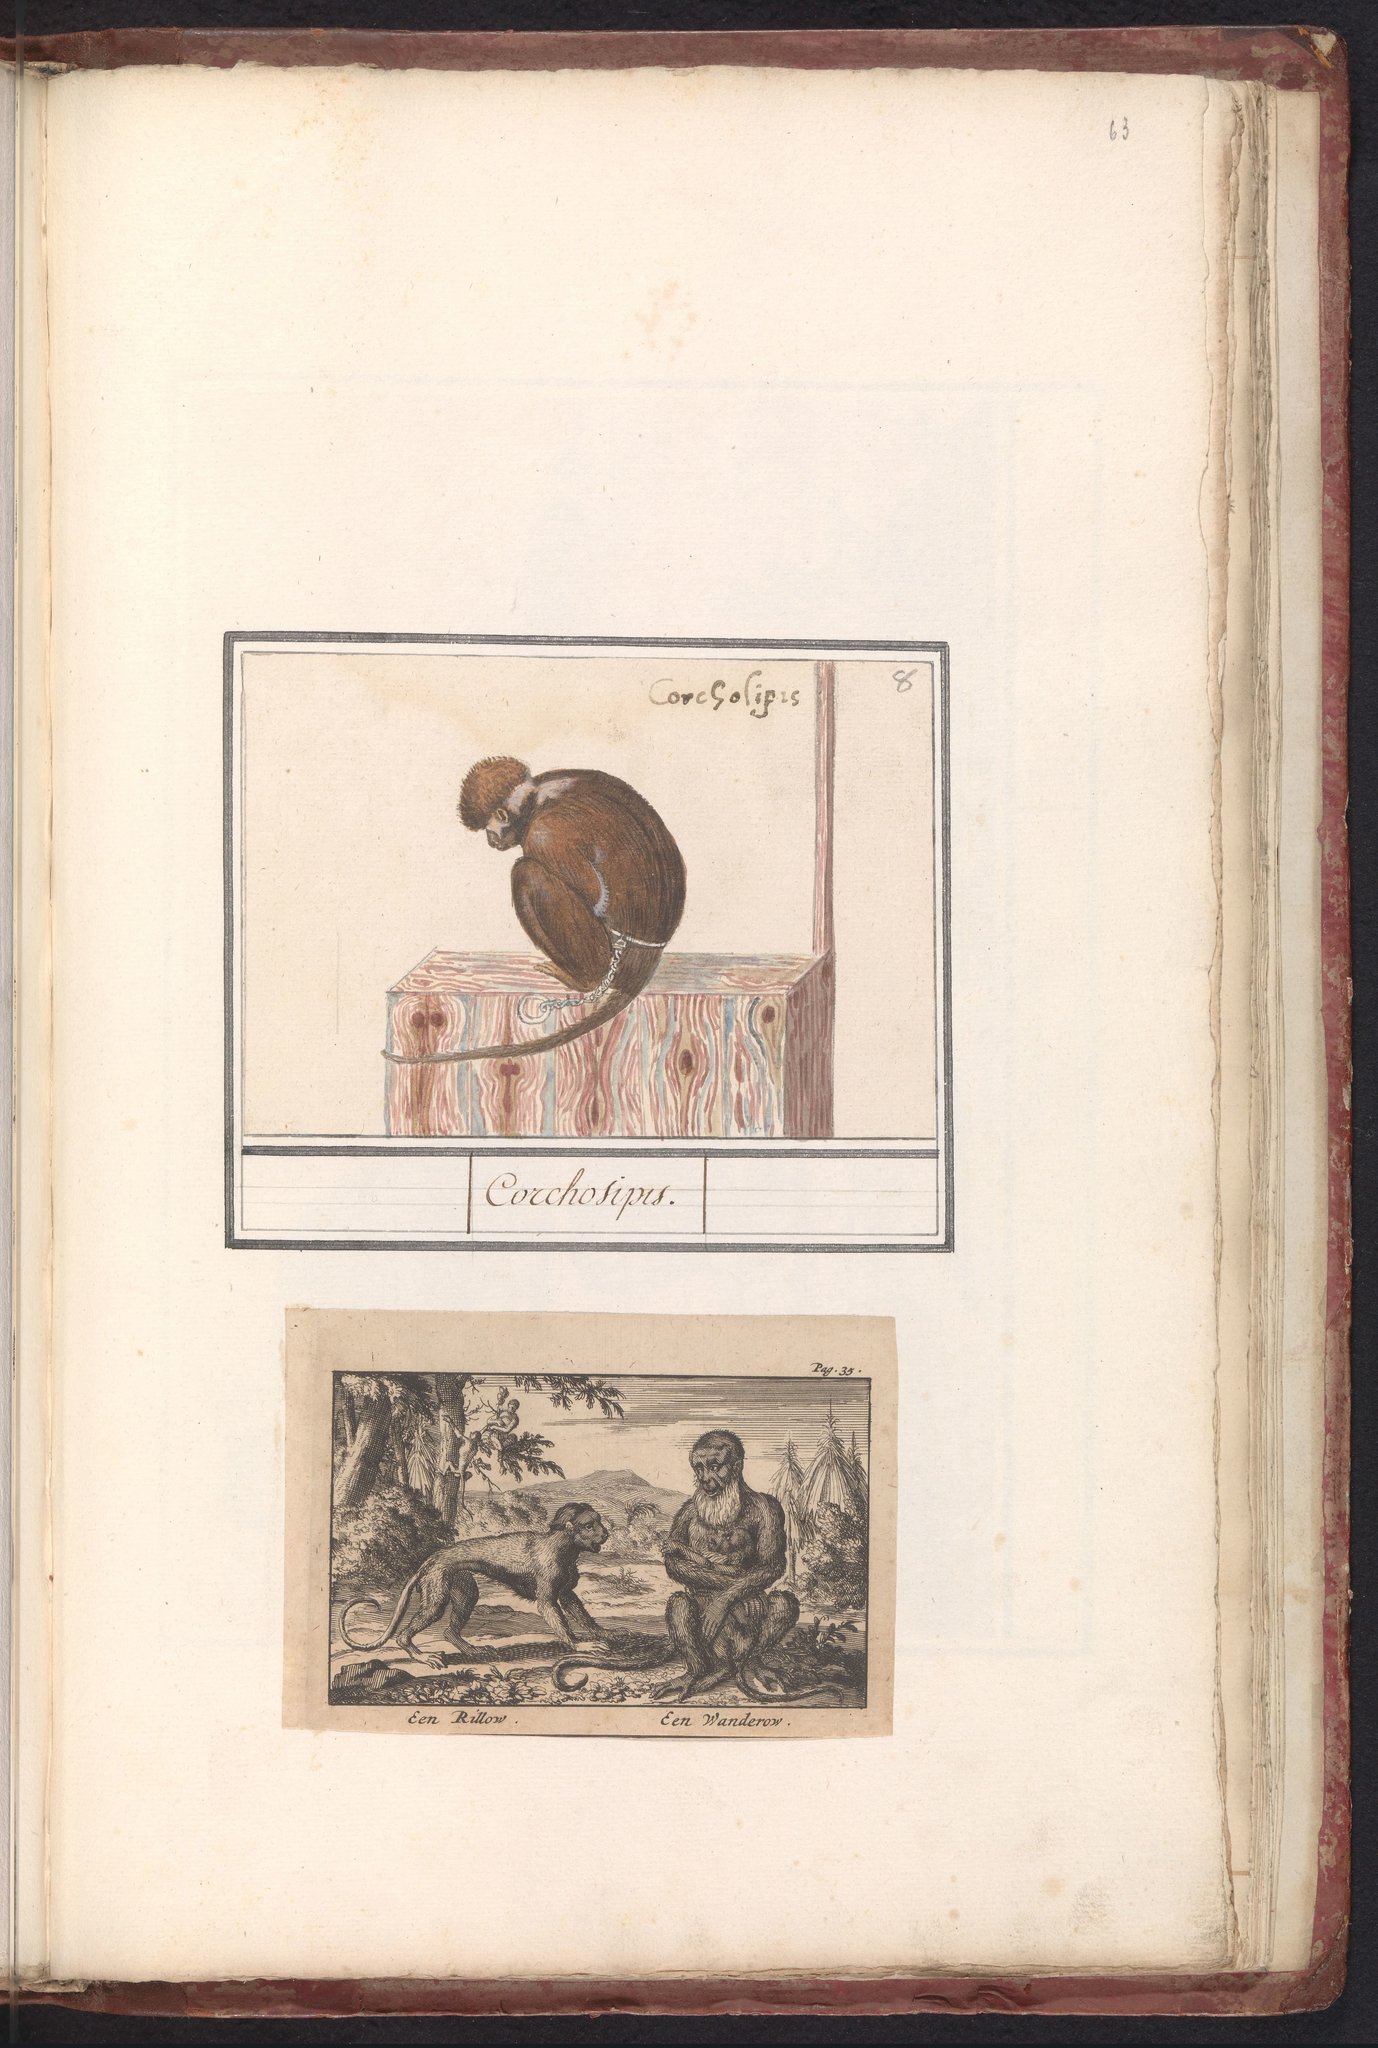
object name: drawing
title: Corchosipus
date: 1596-1610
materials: paint, ink, paper, pencil, watercolor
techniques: brush, etching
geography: netherlands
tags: monkeys, apes: collared mangabey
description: Tekening van een roodkopmangabey aan een ketting en een ingeplakte prent met twee apen. Genummerd rechtsboven: 8. Onderdeel van het tweede album met tekeningen van viervoeters. Tweede van twaalf albums met tekeningen van dieren, vogels en planten bekend rond 1600, gemaakt in opdracht van keizer Rudolf II. Met toelichting in Nederlands, Latijn en Frans.